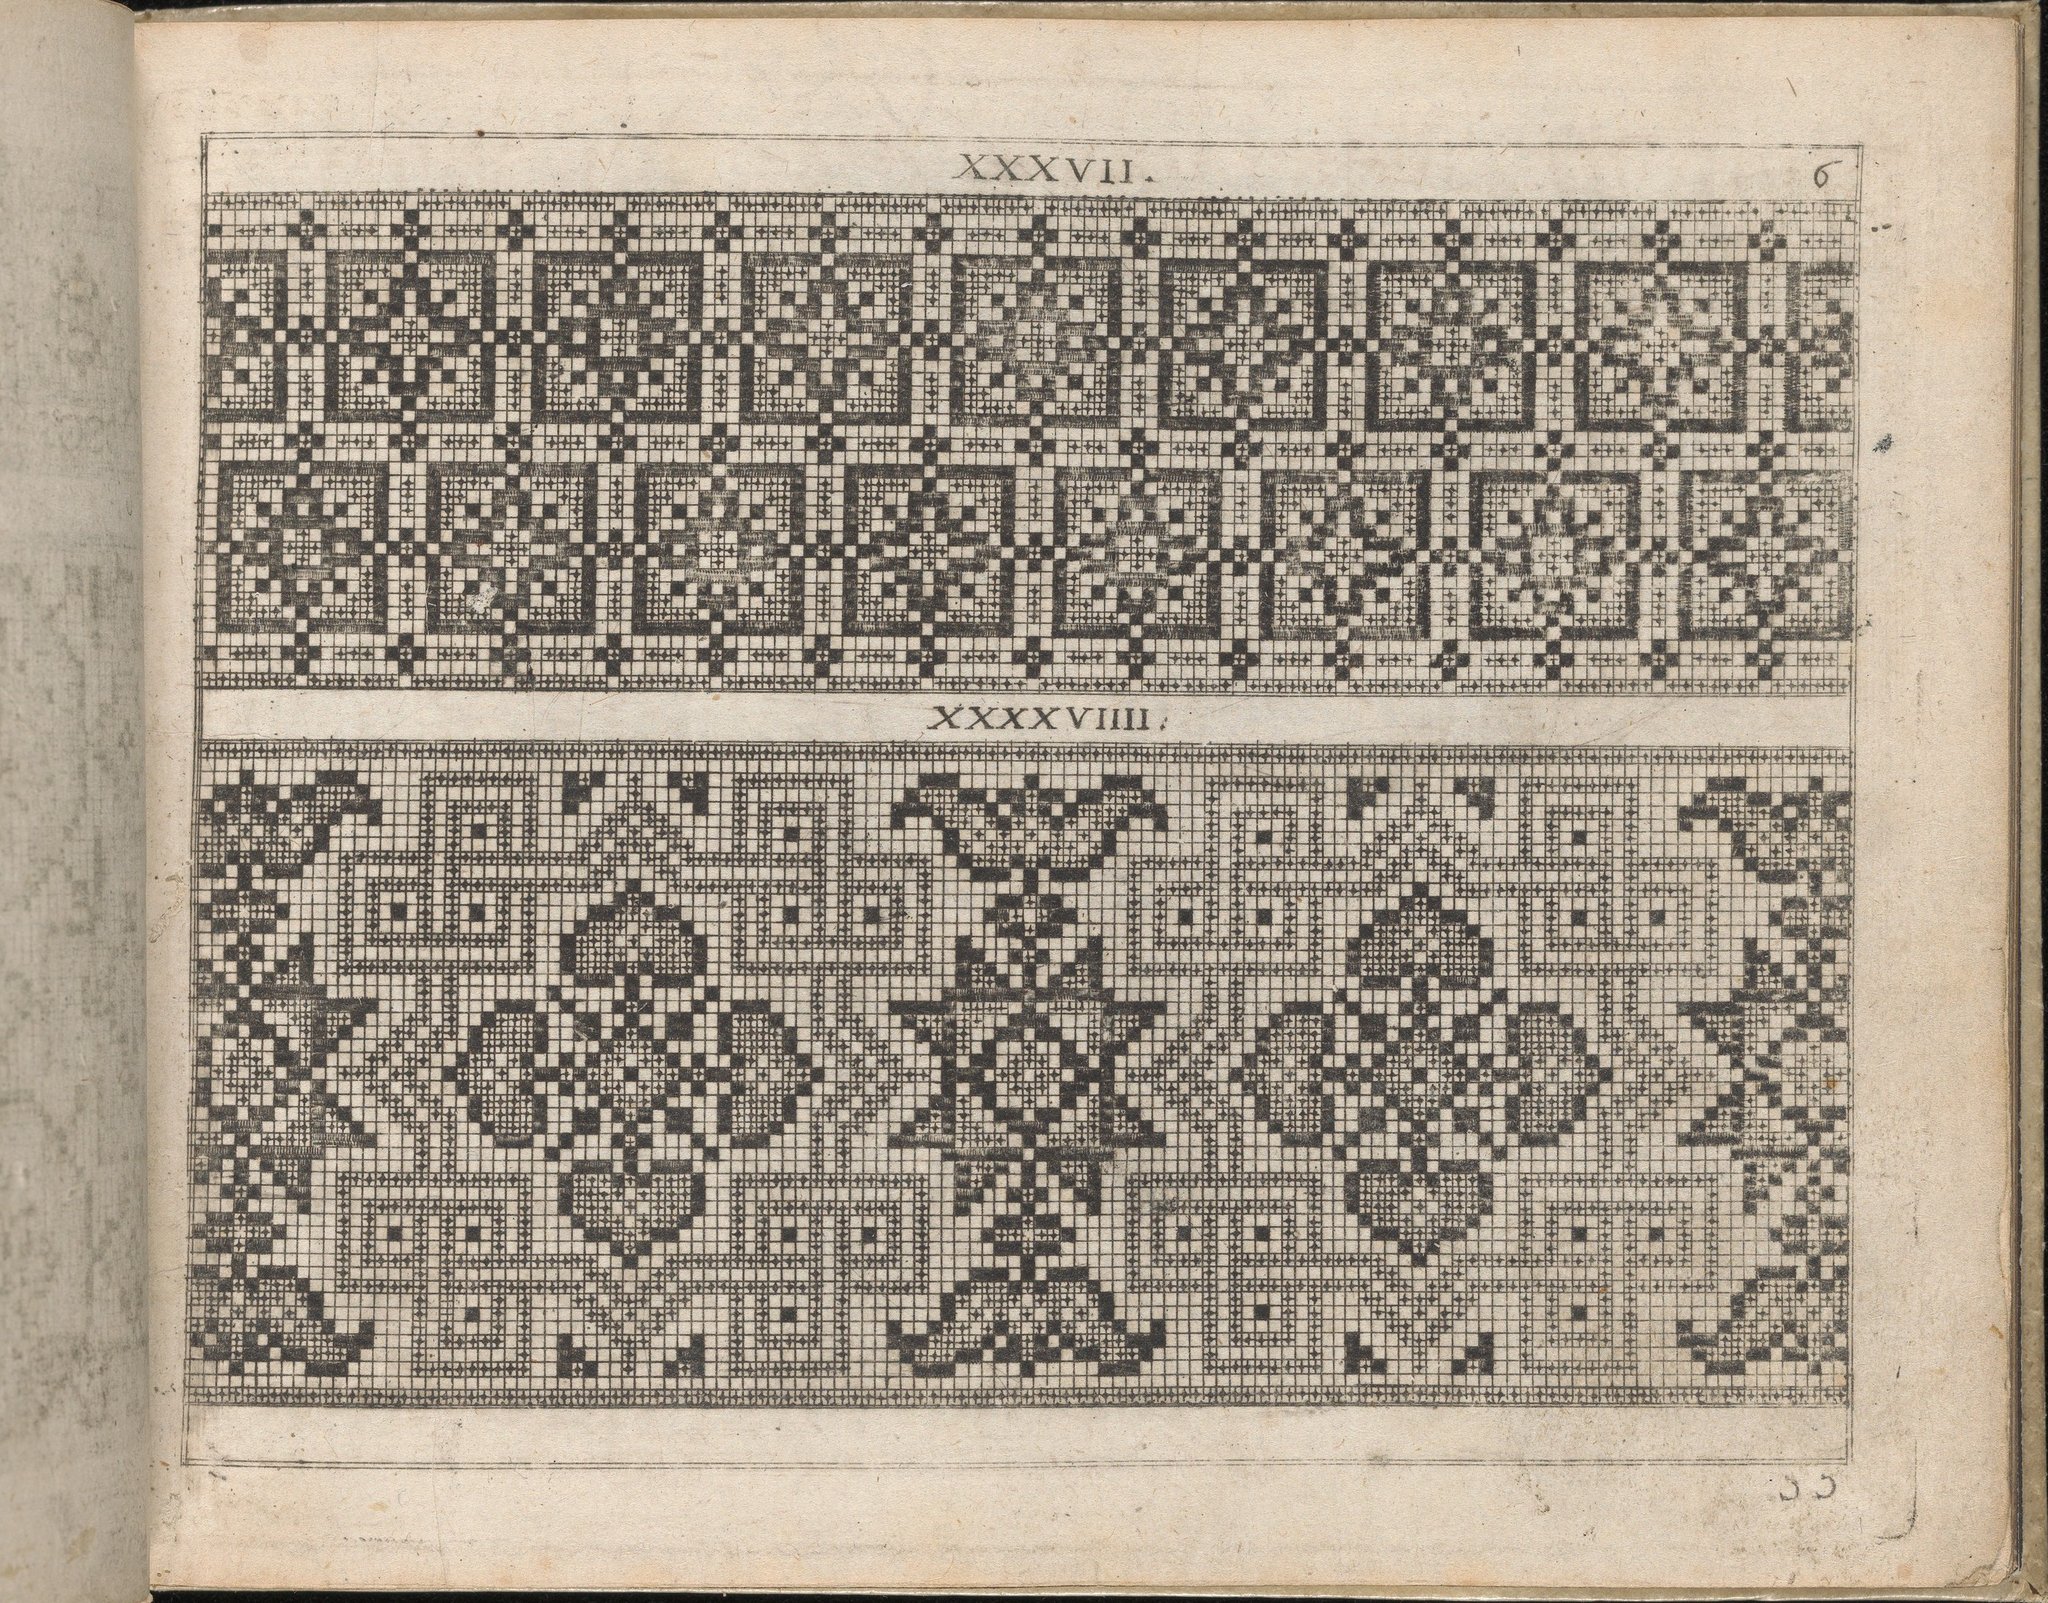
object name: book print ornament architecture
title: Newes Modelbuch in Kupffer (Page 15r)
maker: johann sibmacher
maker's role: artist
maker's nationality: german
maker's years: 1590-1611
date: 1604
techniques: etching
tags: ornament